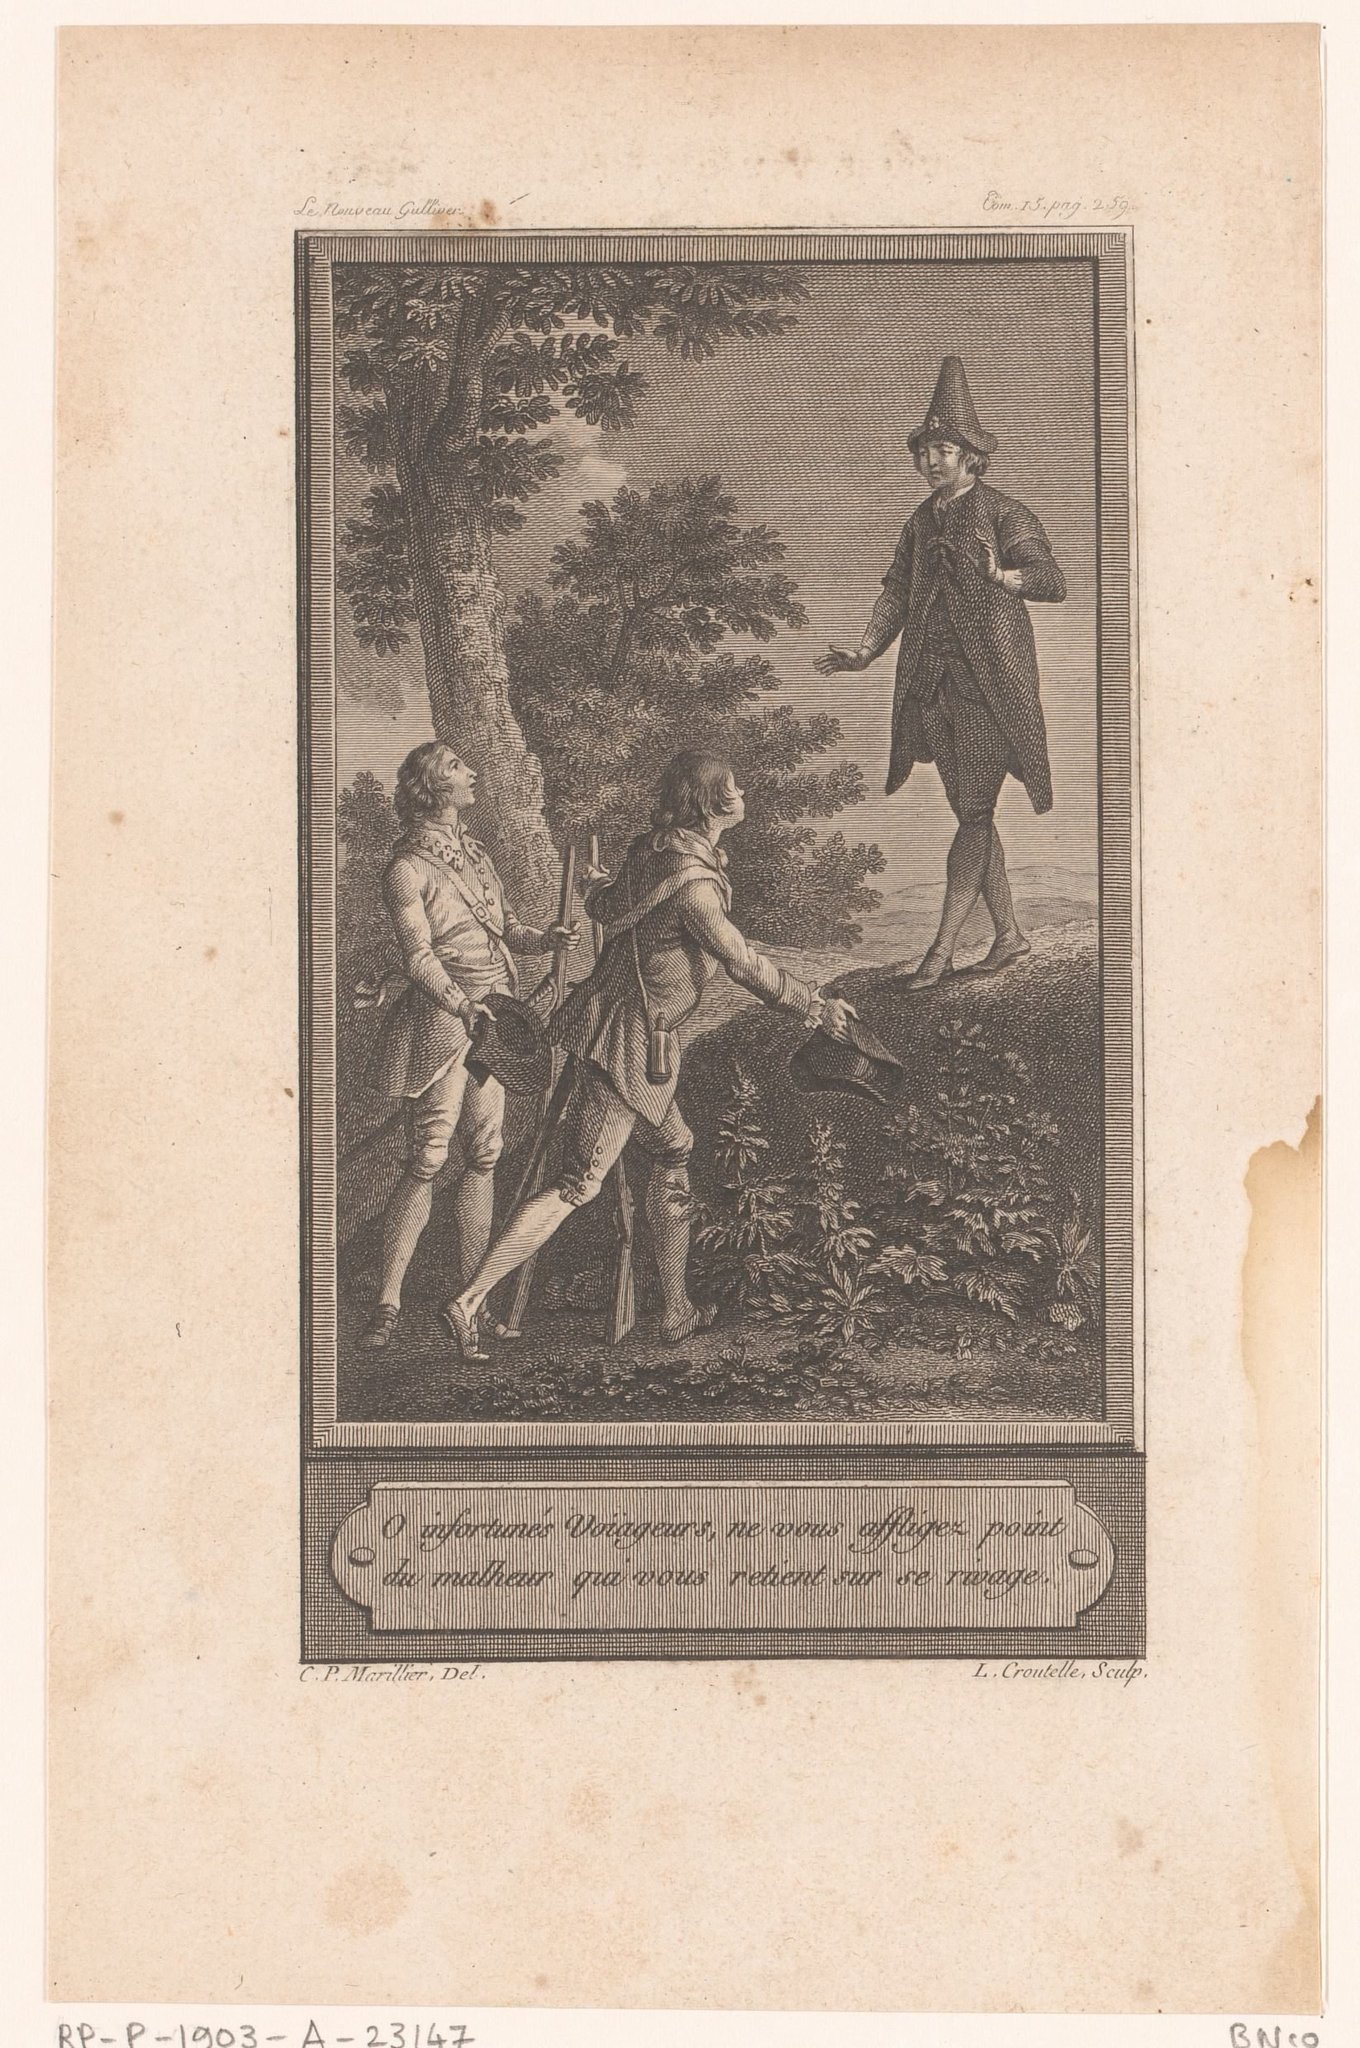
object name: print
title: Man op een steen spreekt twee reizigers aan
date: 1787-1789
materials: paper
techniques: etching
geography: france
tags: (scenes from) specific works of literature: swift, gulliver's travels, 'en route', traveller under way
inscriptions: collector's mark: Lugt 2228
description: Prent uit: Le nouveau Gulliver, Parijs: Charles Garnier, 1787-1789, deel 15, p. 259.